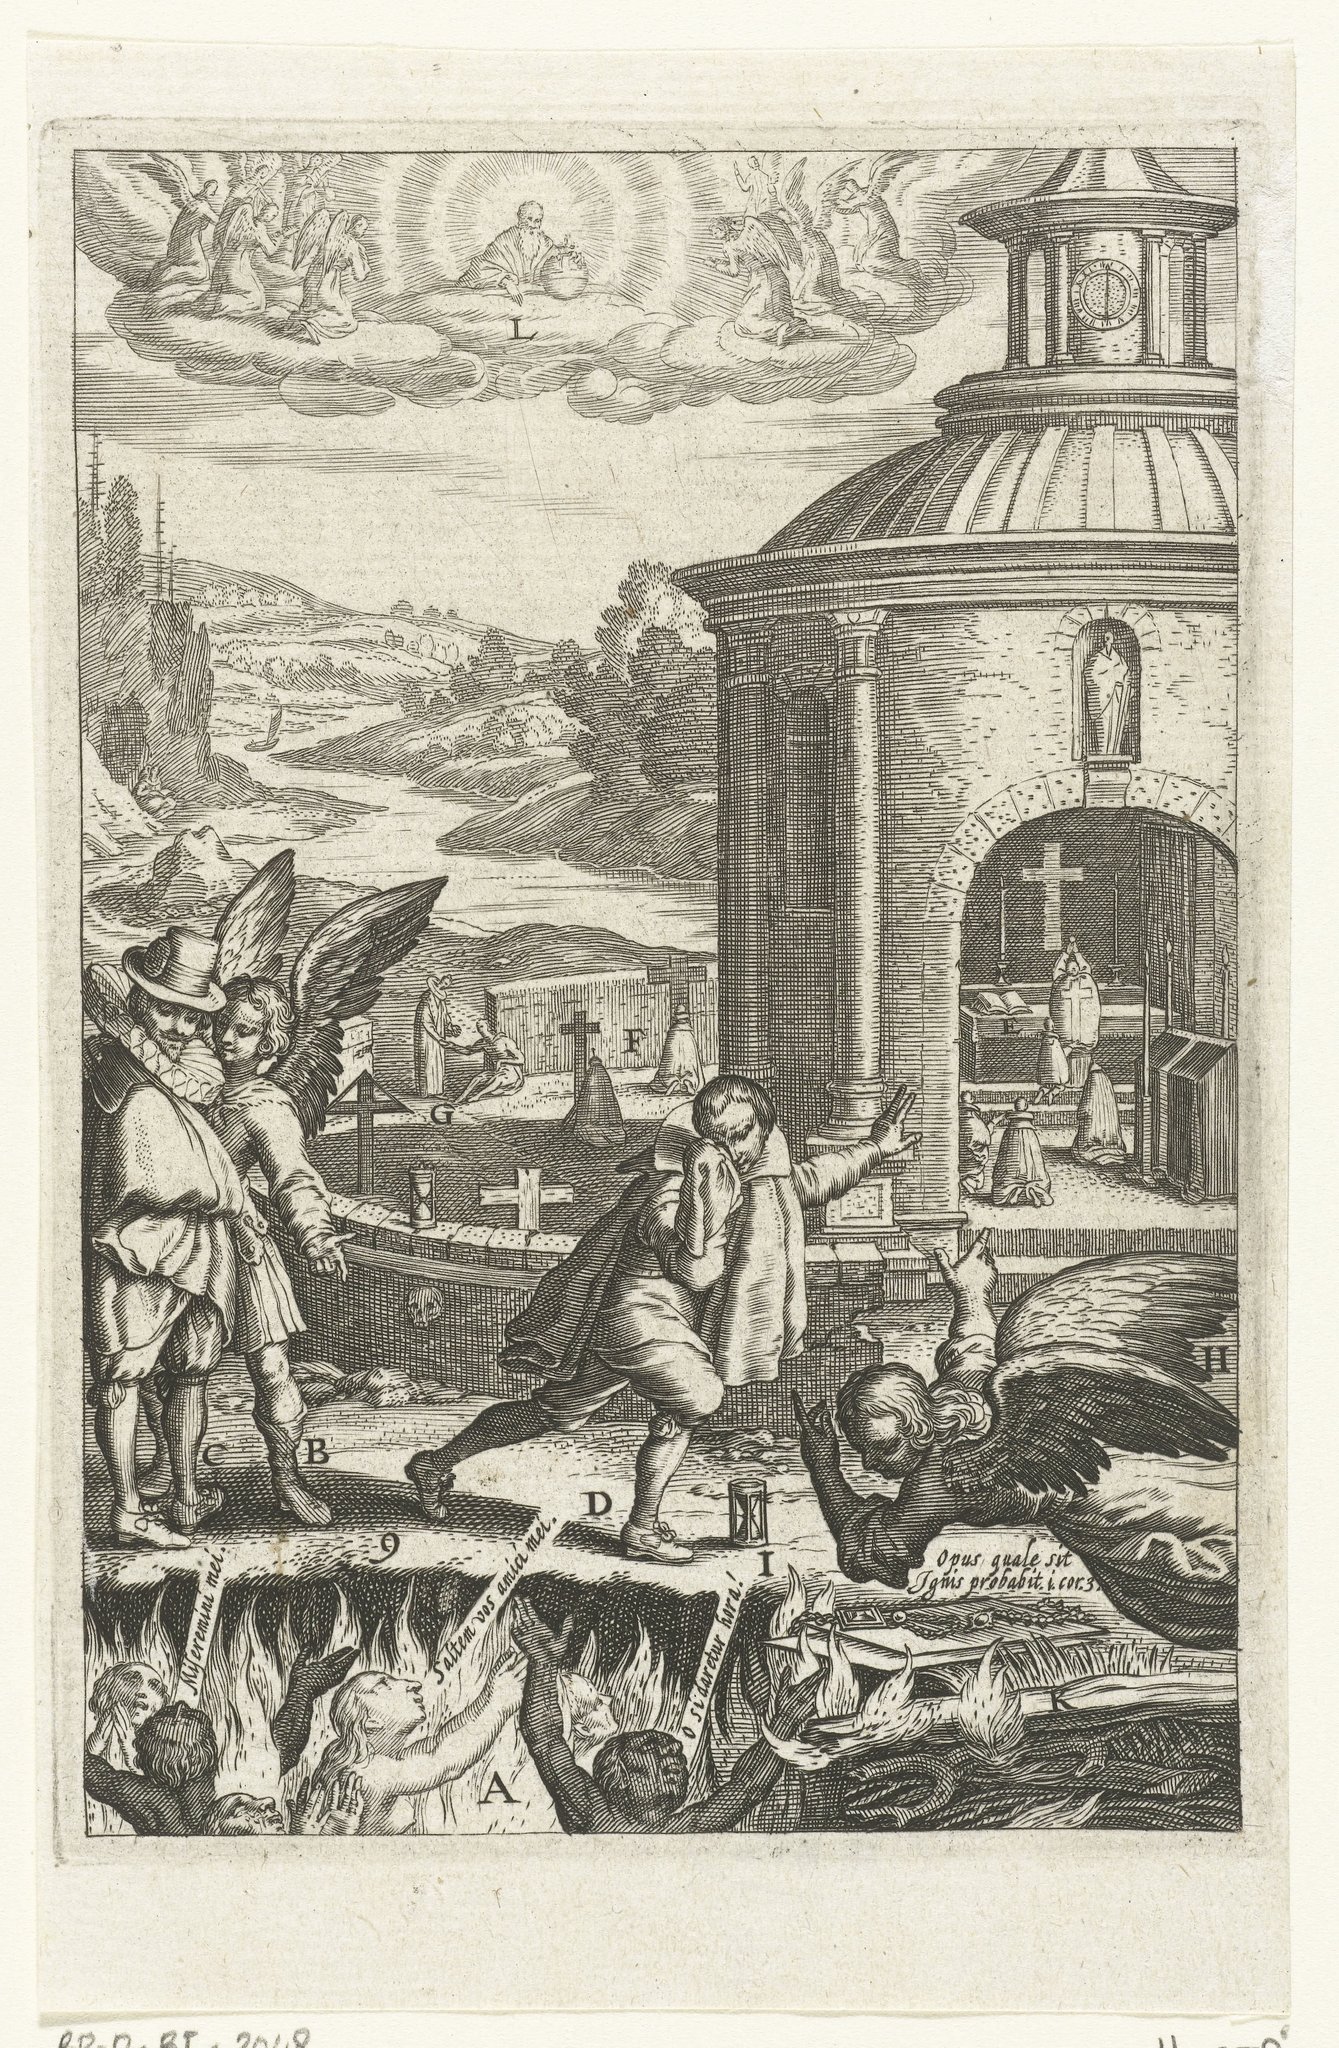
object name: book illustration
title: Embleem met engelen die mannen aanmoedigen om mededogen te hebben met de smekende zielen in het vagevuur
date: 1620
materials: paper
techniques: engraving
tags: church (exterior), guardian angel, (private) prayer; 'oratione', 'preghiere', 'preghiere a dio' (ripa), holy mass (divine service, especially of roman catholic church), purgatory, usually the souls praying or asking for intercession, churchyard (around church), the life of man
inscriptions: collector's mark: Lugt 2228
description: Prent uit: Antoine Sucquet, Den wech des eeuwich levens, beschreven int latijn : met beelden verlicht door Boëtius a Bolsvert, Antwerpen, Hendrick Aertssens, 1620, afb. tegenover p. 238